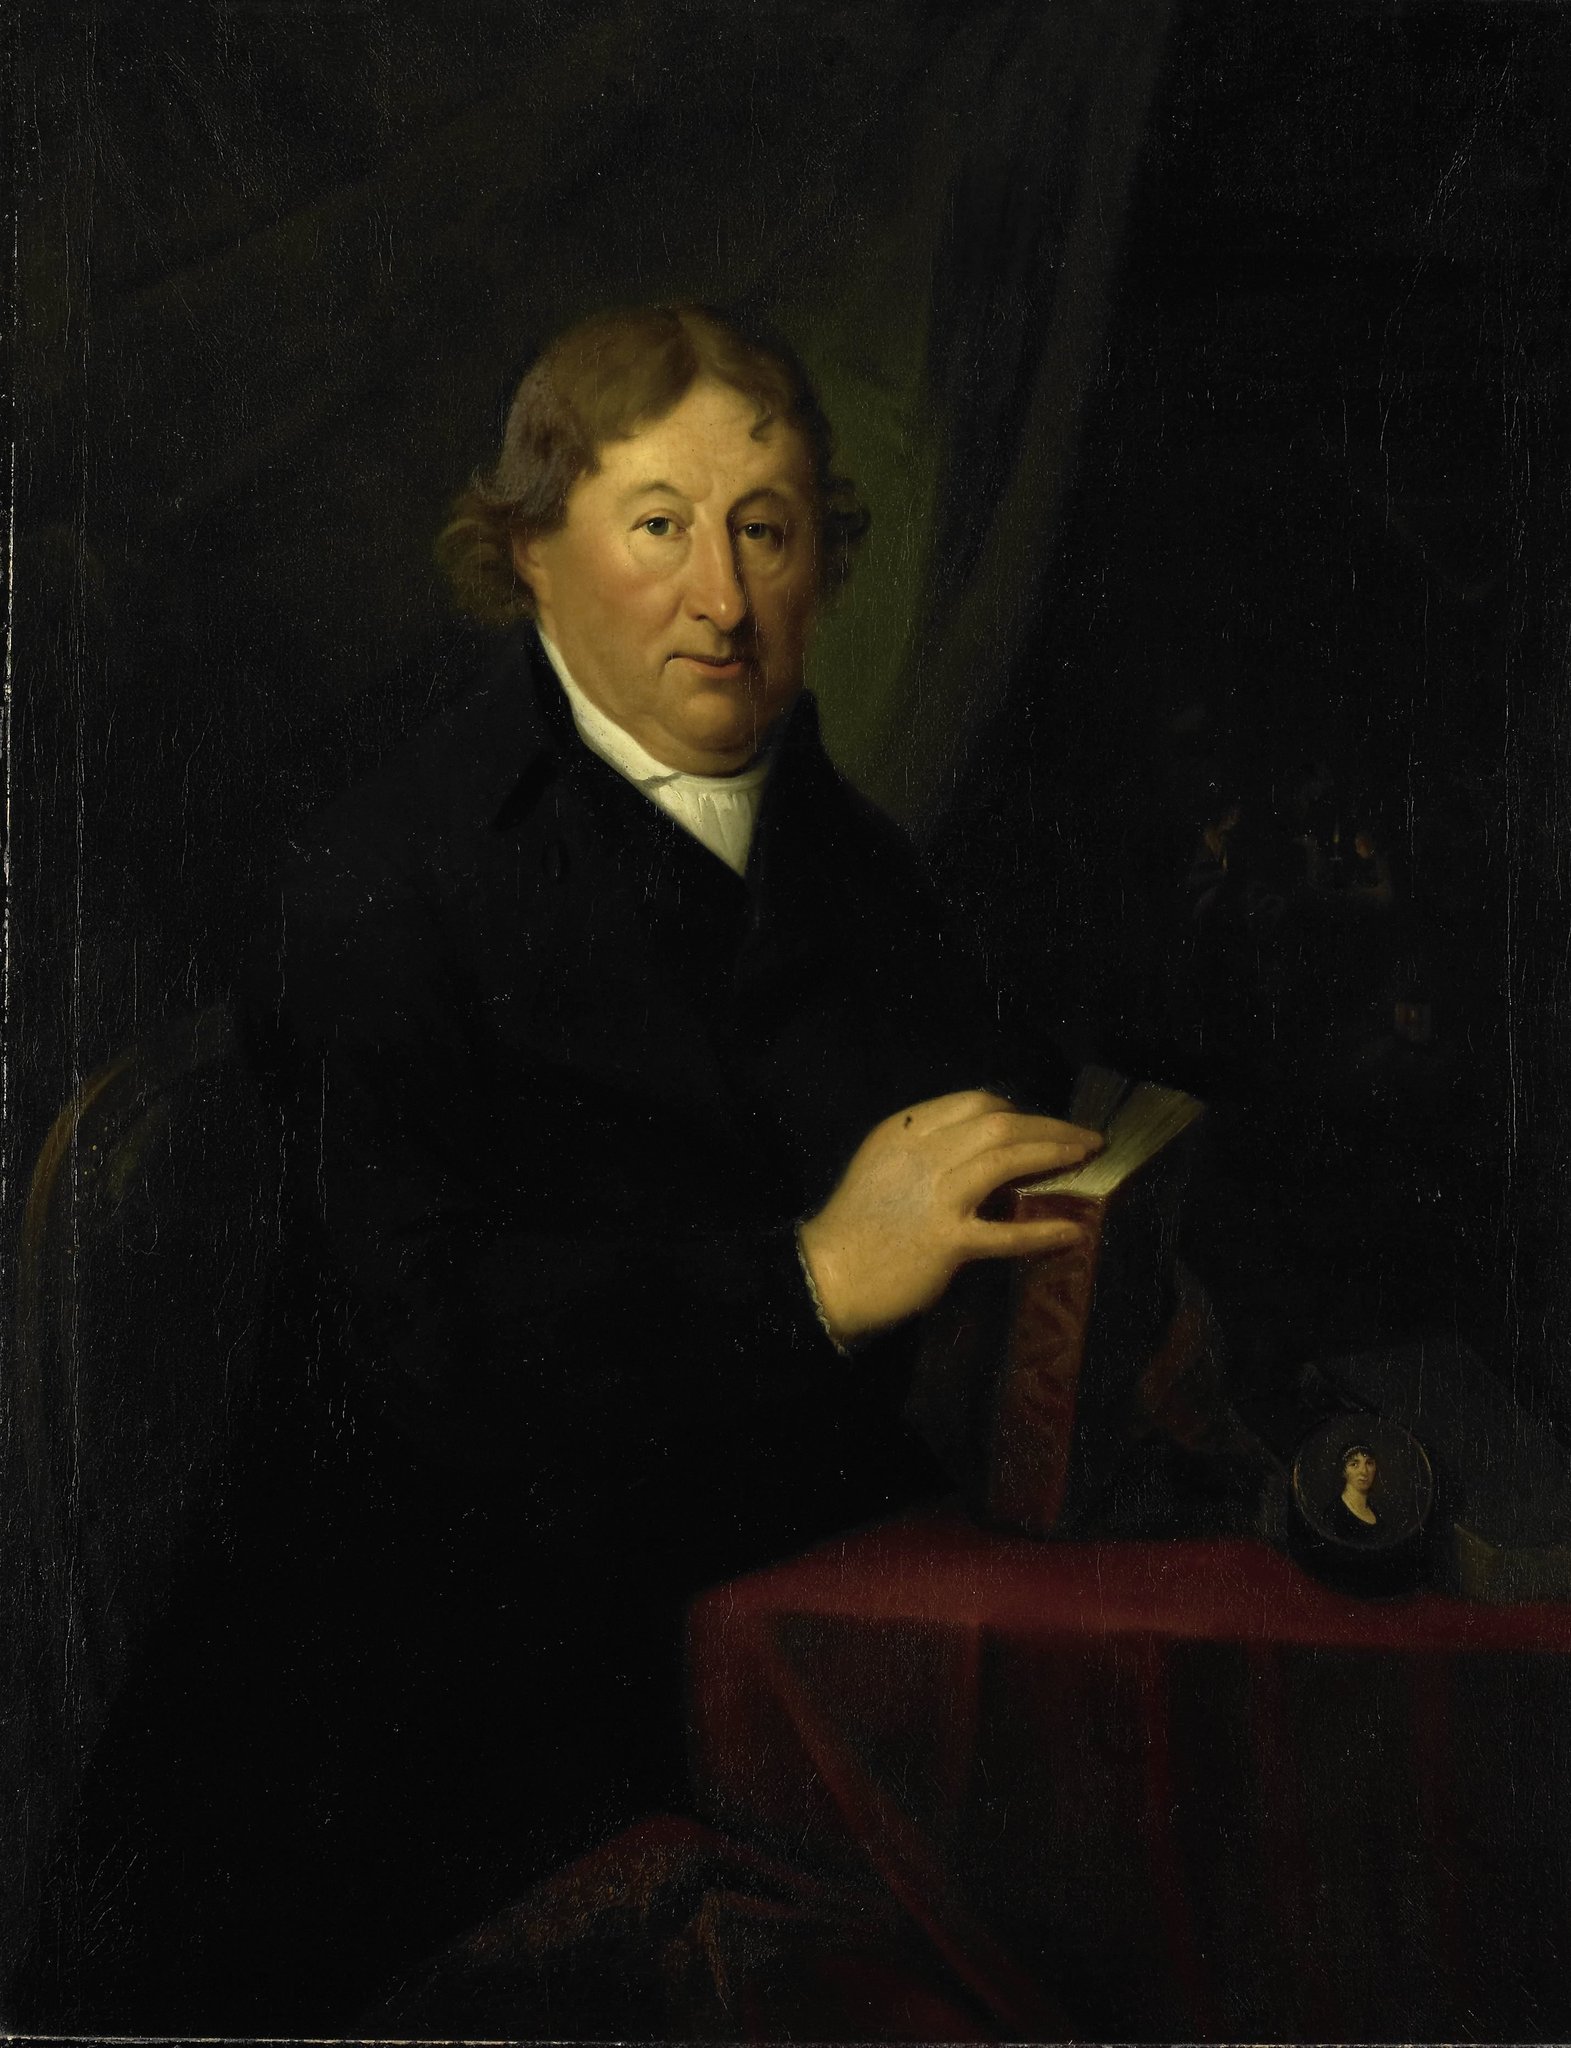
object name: painting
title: Portrait of Gerrit van der Pot, Lord of Groeneveld, Art Collector in Rotterdam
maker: johan bernard scheffer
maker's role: draughtsman, painter, print maker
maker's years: 1765-1809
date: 1800-1807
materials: canvas, oil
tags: rotterdam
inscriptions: signature: ‘J.B. Scheffer’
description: Portret van Gerrit van der Pot (1732-1807), heer van Groeneveld, kunstverzamelaar te Rotterdam. Ten halven lijve, zittend aan een tafel met in zijn handen het journaal waarin hij zijn aanwinsten noteerde. Op tafel ligt een posthuum miniatuurportretje (1800) van zijn derde vrouw Maria Catharina Pelerin (gest. 1799) door Gijsbertus Johannes van den Berg. Rechts op de achtergrond het schilderij De Avondschool door Gerrit Dou (SK-A-87).